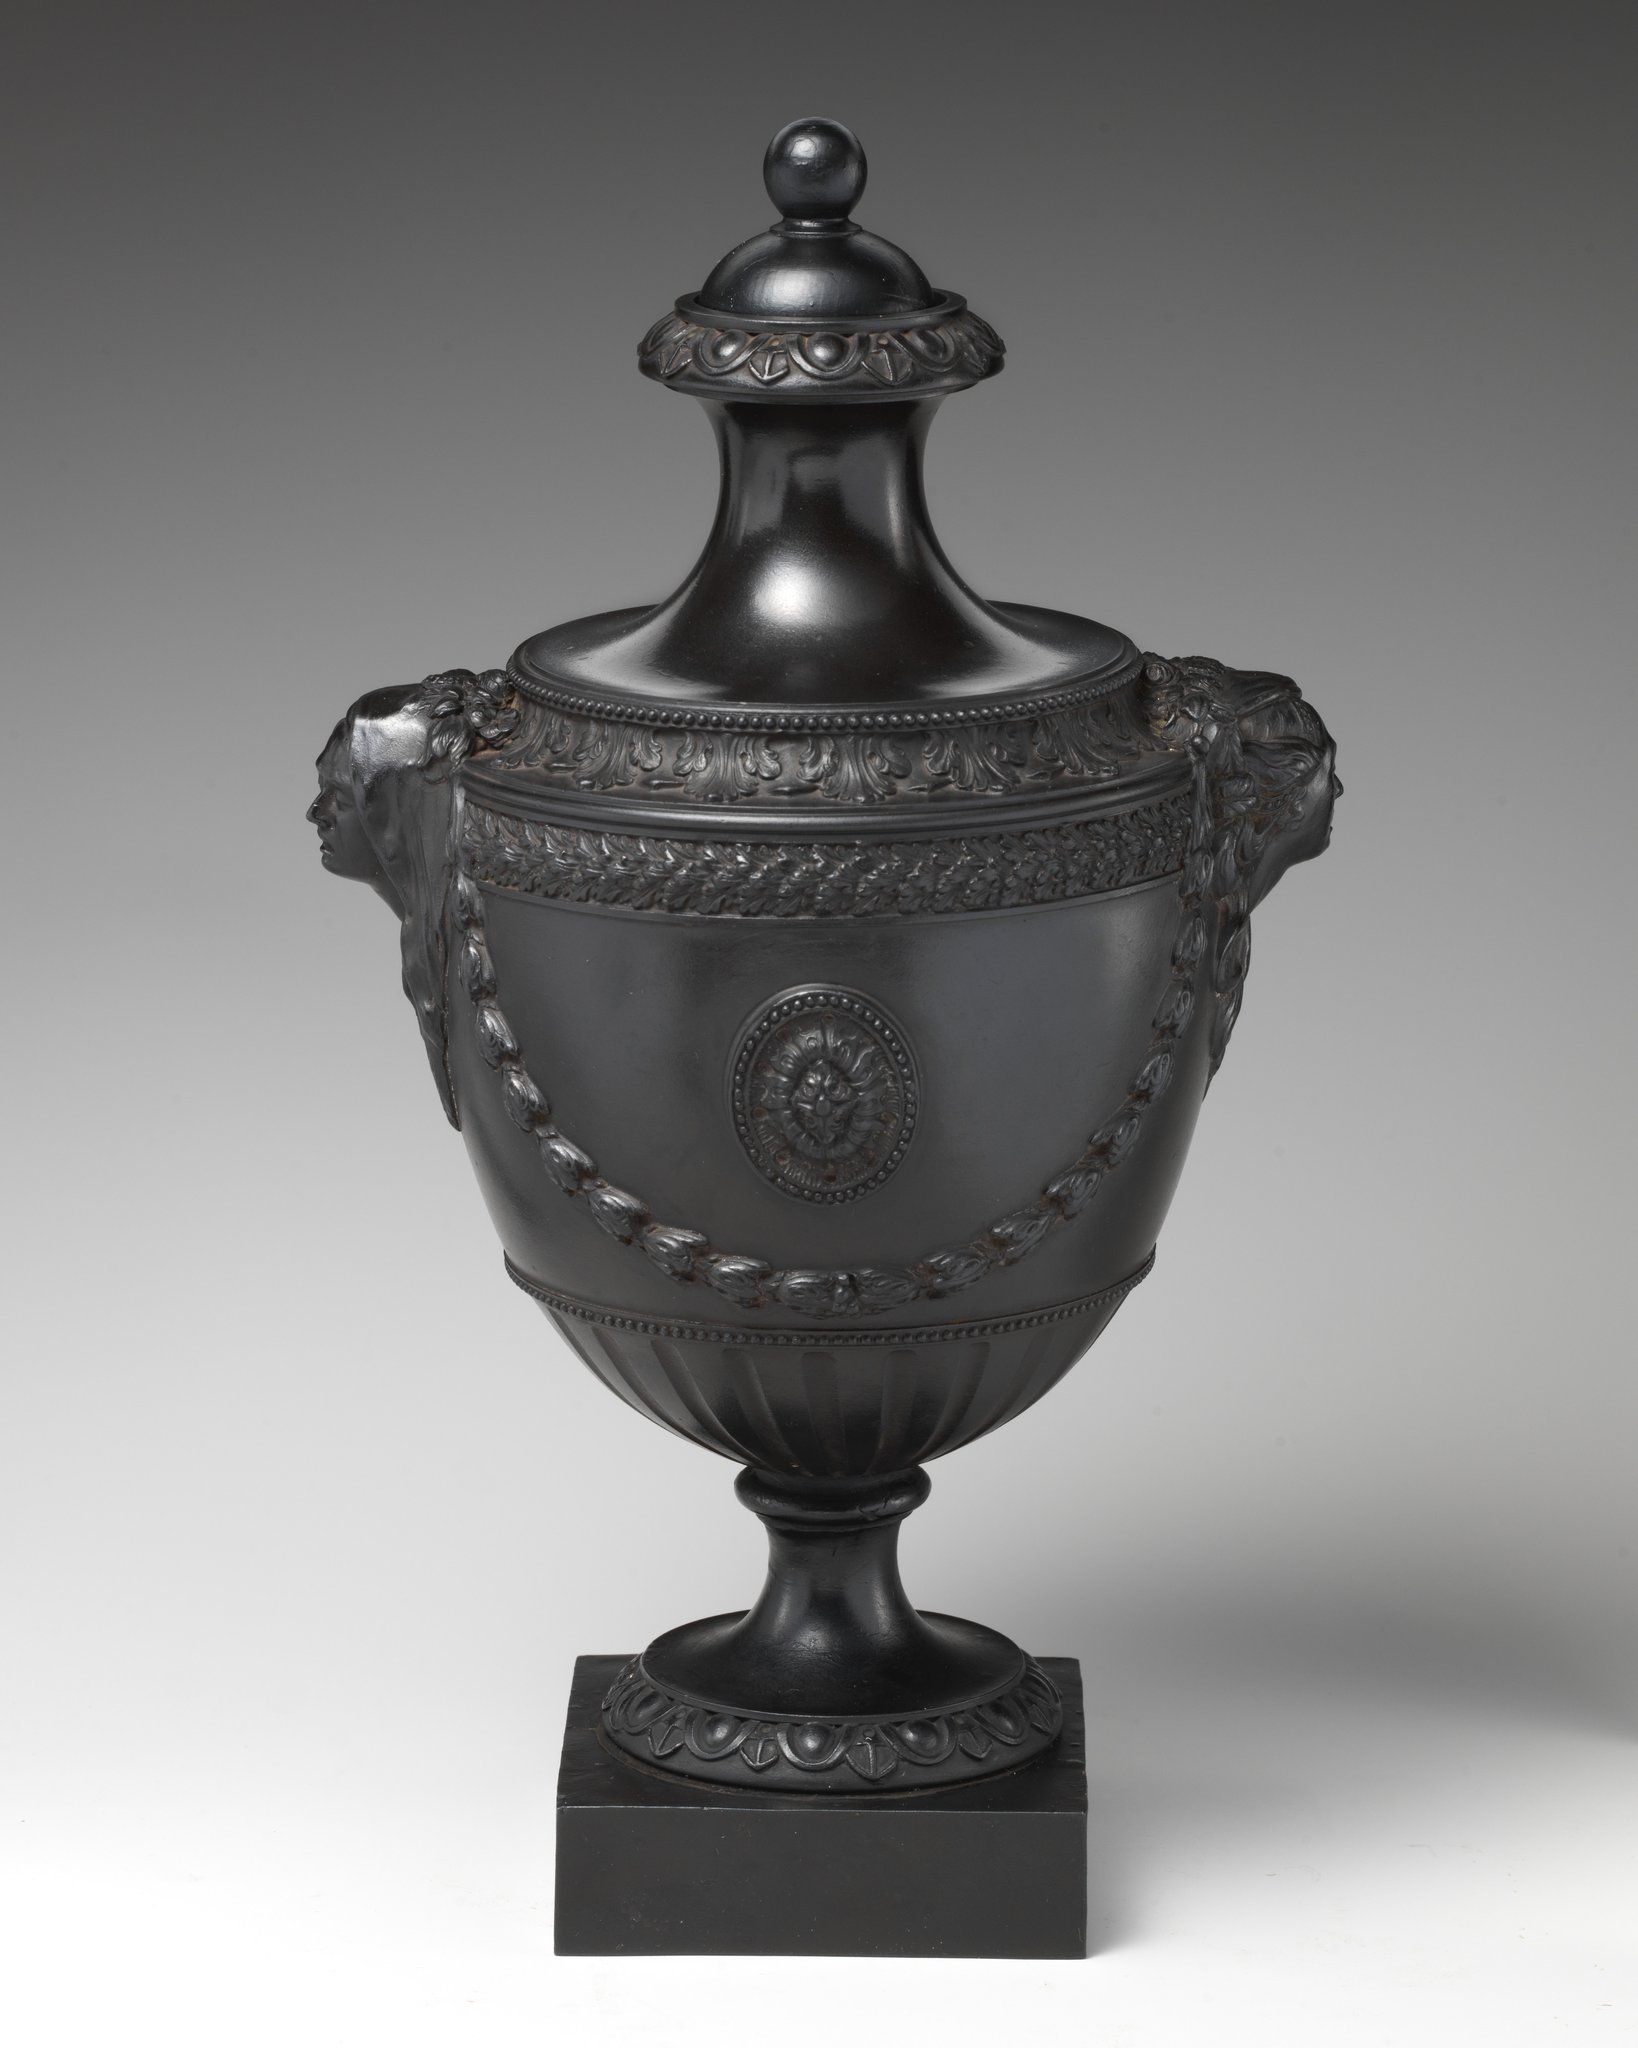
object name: urn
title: Urn (one of a pair)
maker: james neale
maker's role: maker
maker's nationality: british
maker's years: 1739-1814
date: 1778-1780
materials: stone